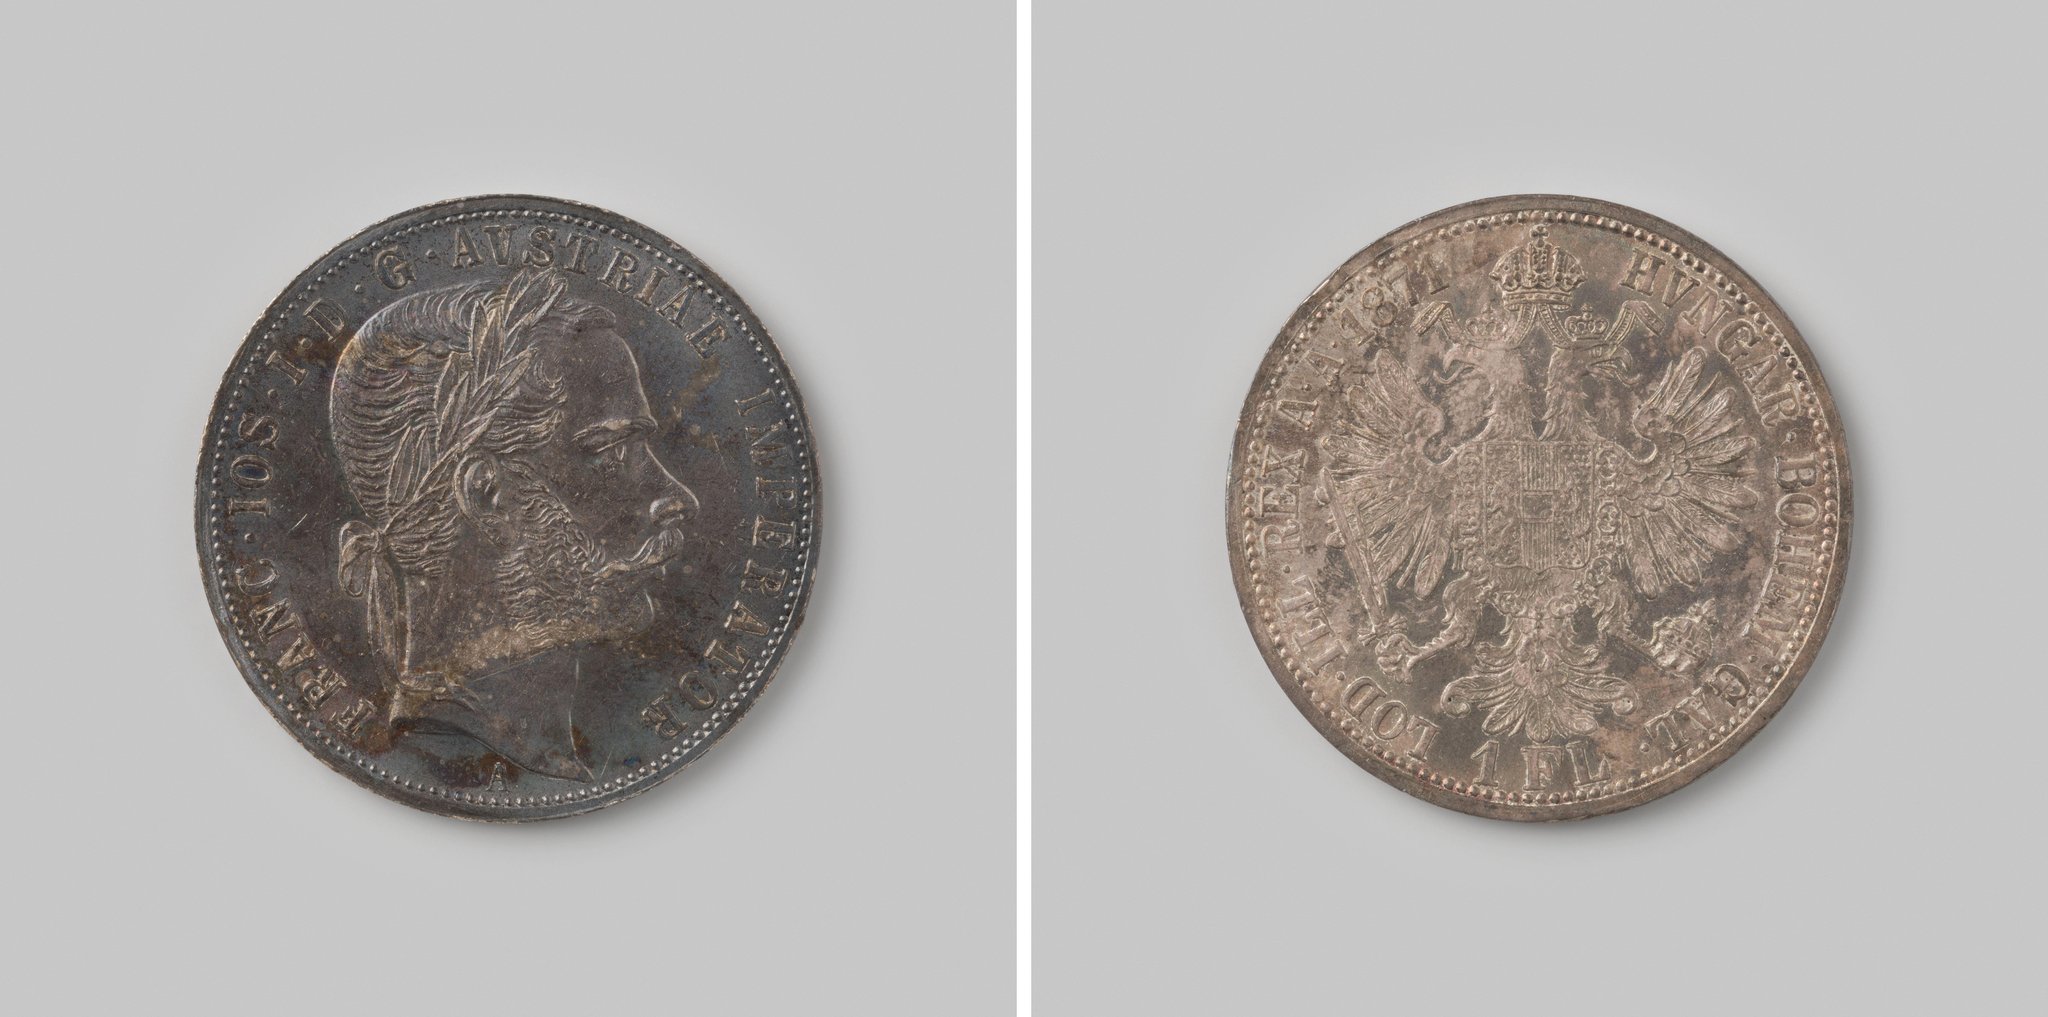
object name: coin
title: Keizerrijk Oostenrijk, gulden, Franz Joseph, 1871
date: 1871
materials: silver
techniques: striking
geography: vienna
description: Zilveren munt. Voorzijde: gelauwerd hoofd van de keizer naar rechts, waaronder letter A [=Wenen]. Keerzijde: gekroonde dubbelkoppige adelaar met op de koppen kleine kronen. Op zijn borst door ridderorde met juweel omhangen samengesteld wapenschild en in zijn poten een zwaard en een rijksappel. Waarde-aanduiding, 1 FL onderaan, jaartal aan het eind van het omschrift. Randschrift.